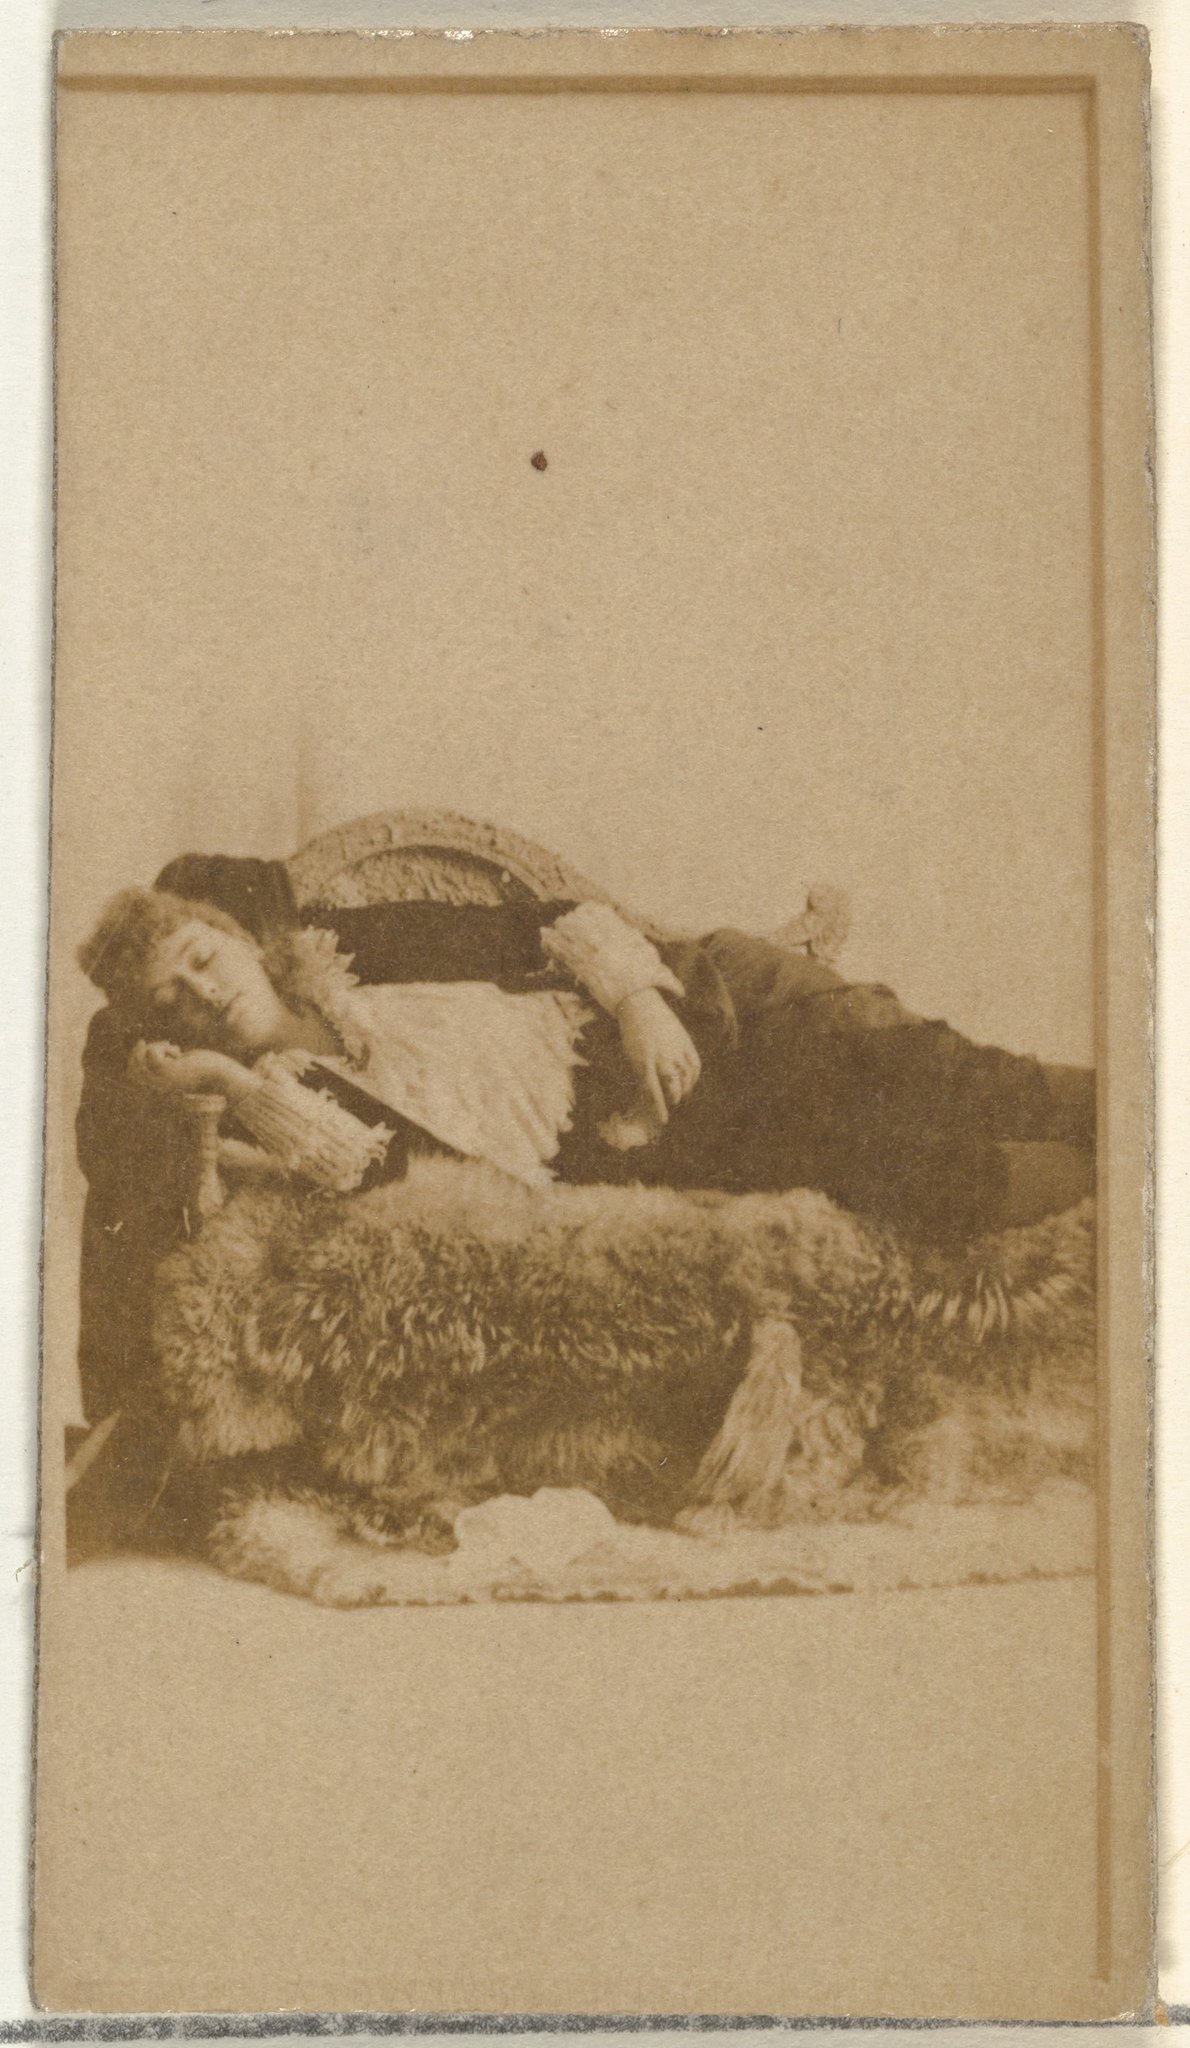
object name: photograph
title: [Actress reclining on furs], from the Actors and Actresses series (N145-8) issued by Duke Sons & Co. to promote Duke Cigarettes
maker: w. duke, sons & co.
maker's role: publisher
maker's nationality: american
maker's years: 1870-1920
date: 1891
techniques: albumen silver print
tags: sleeping,portraits,women,actresses